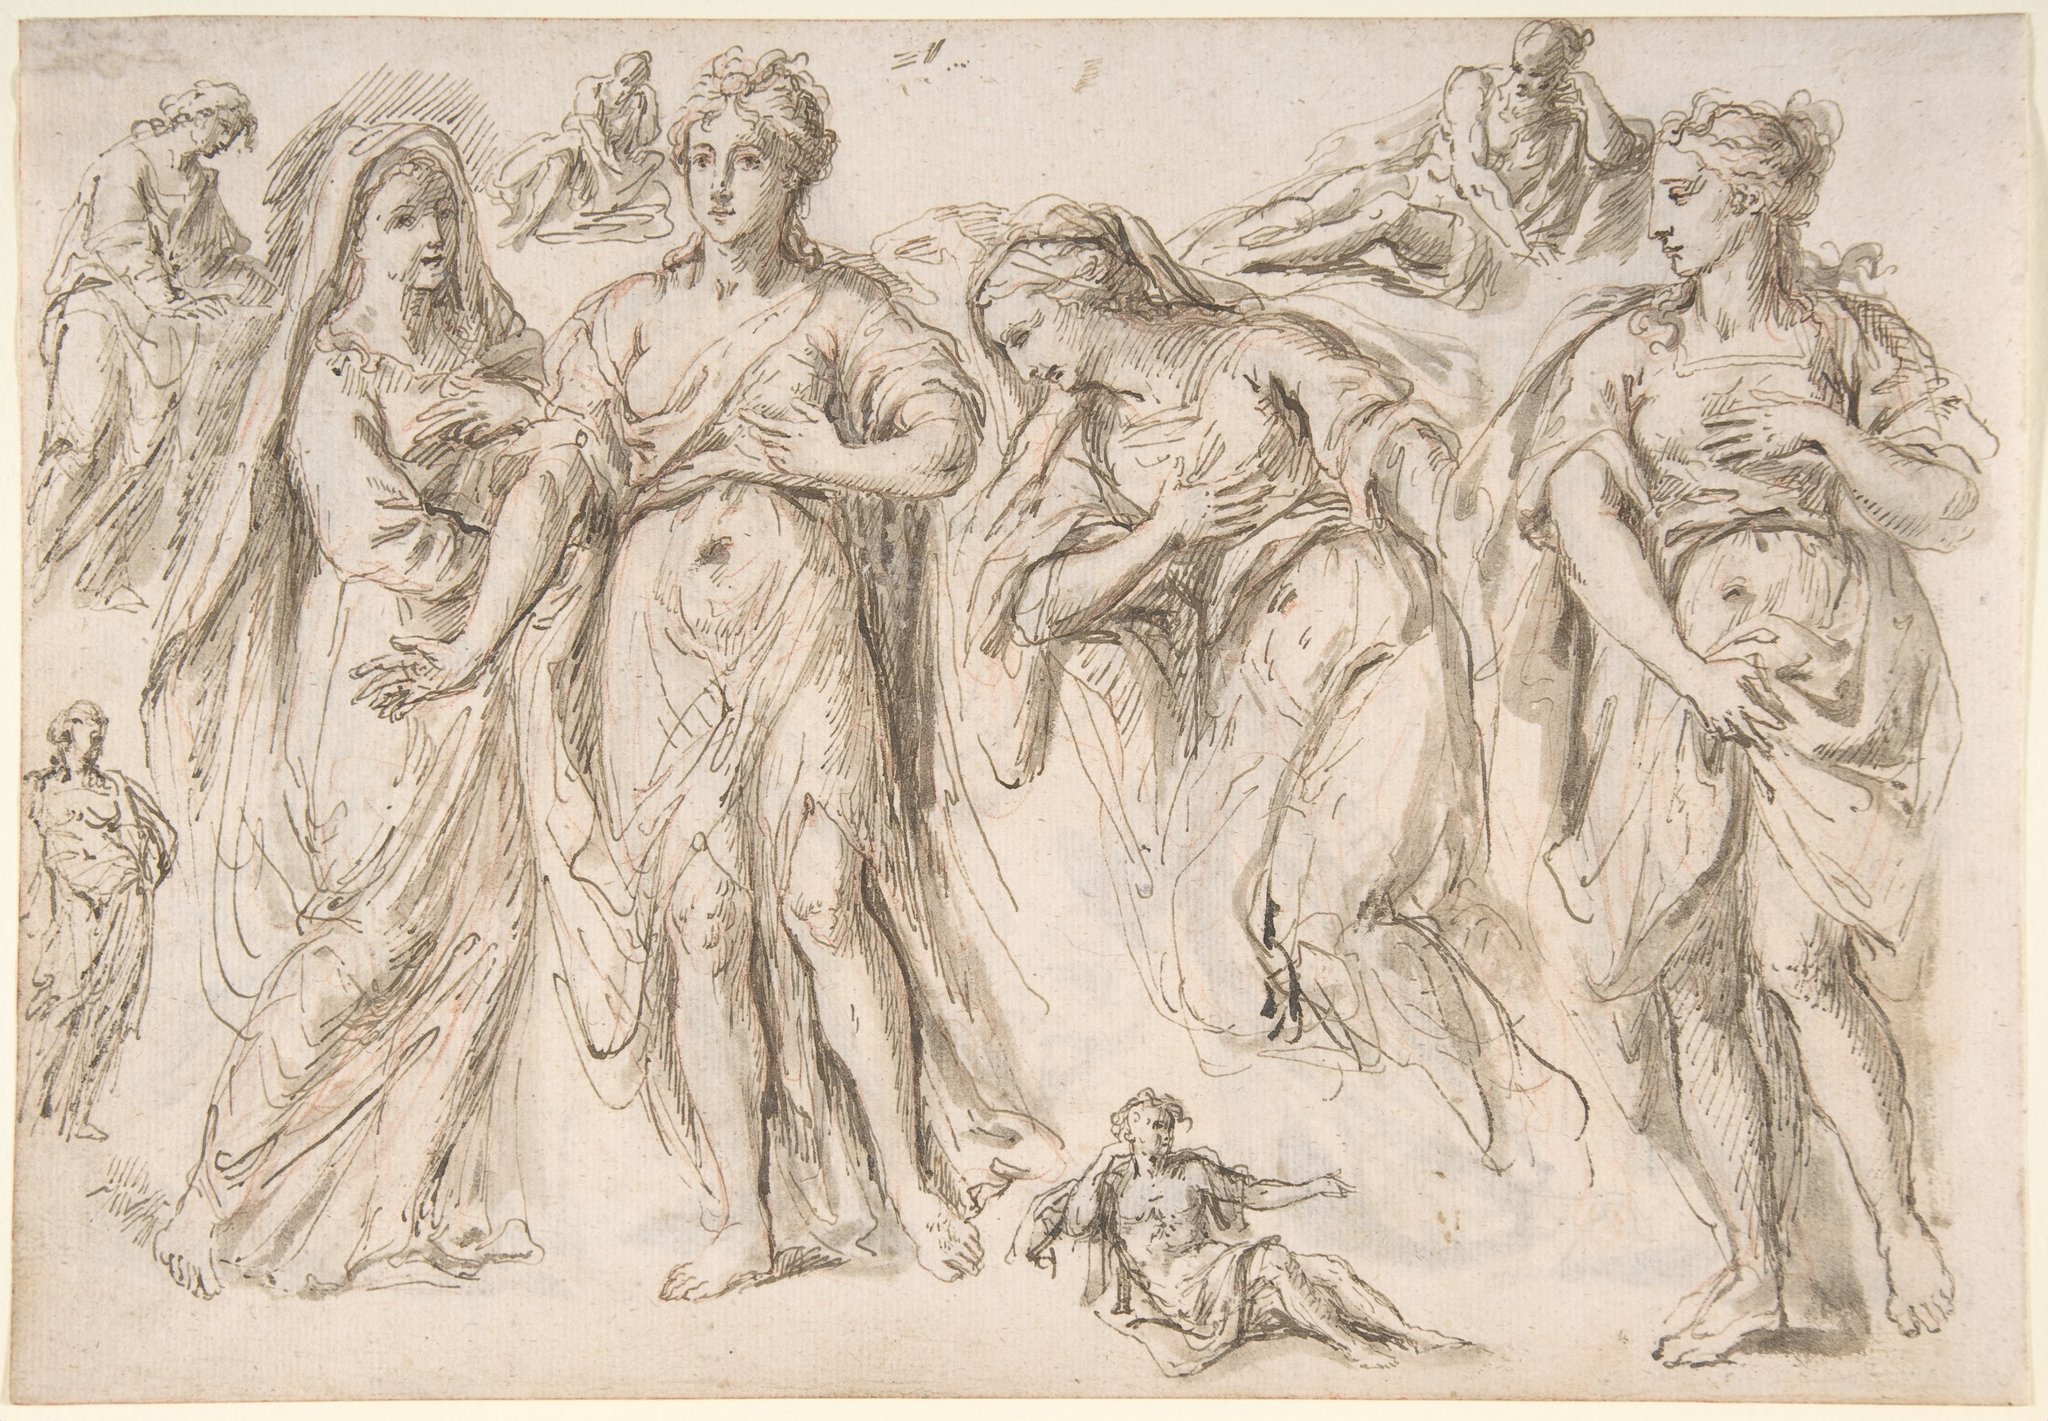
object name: drawing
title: Studies of draped female and male figures; verso: Studies of draped female figures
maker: bartholomaeus ignaz weiss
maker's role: artist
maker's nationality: german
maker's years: 1730-1814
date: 1701-1833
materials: chalk, ink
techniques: pen, wash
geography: germany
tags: men,women